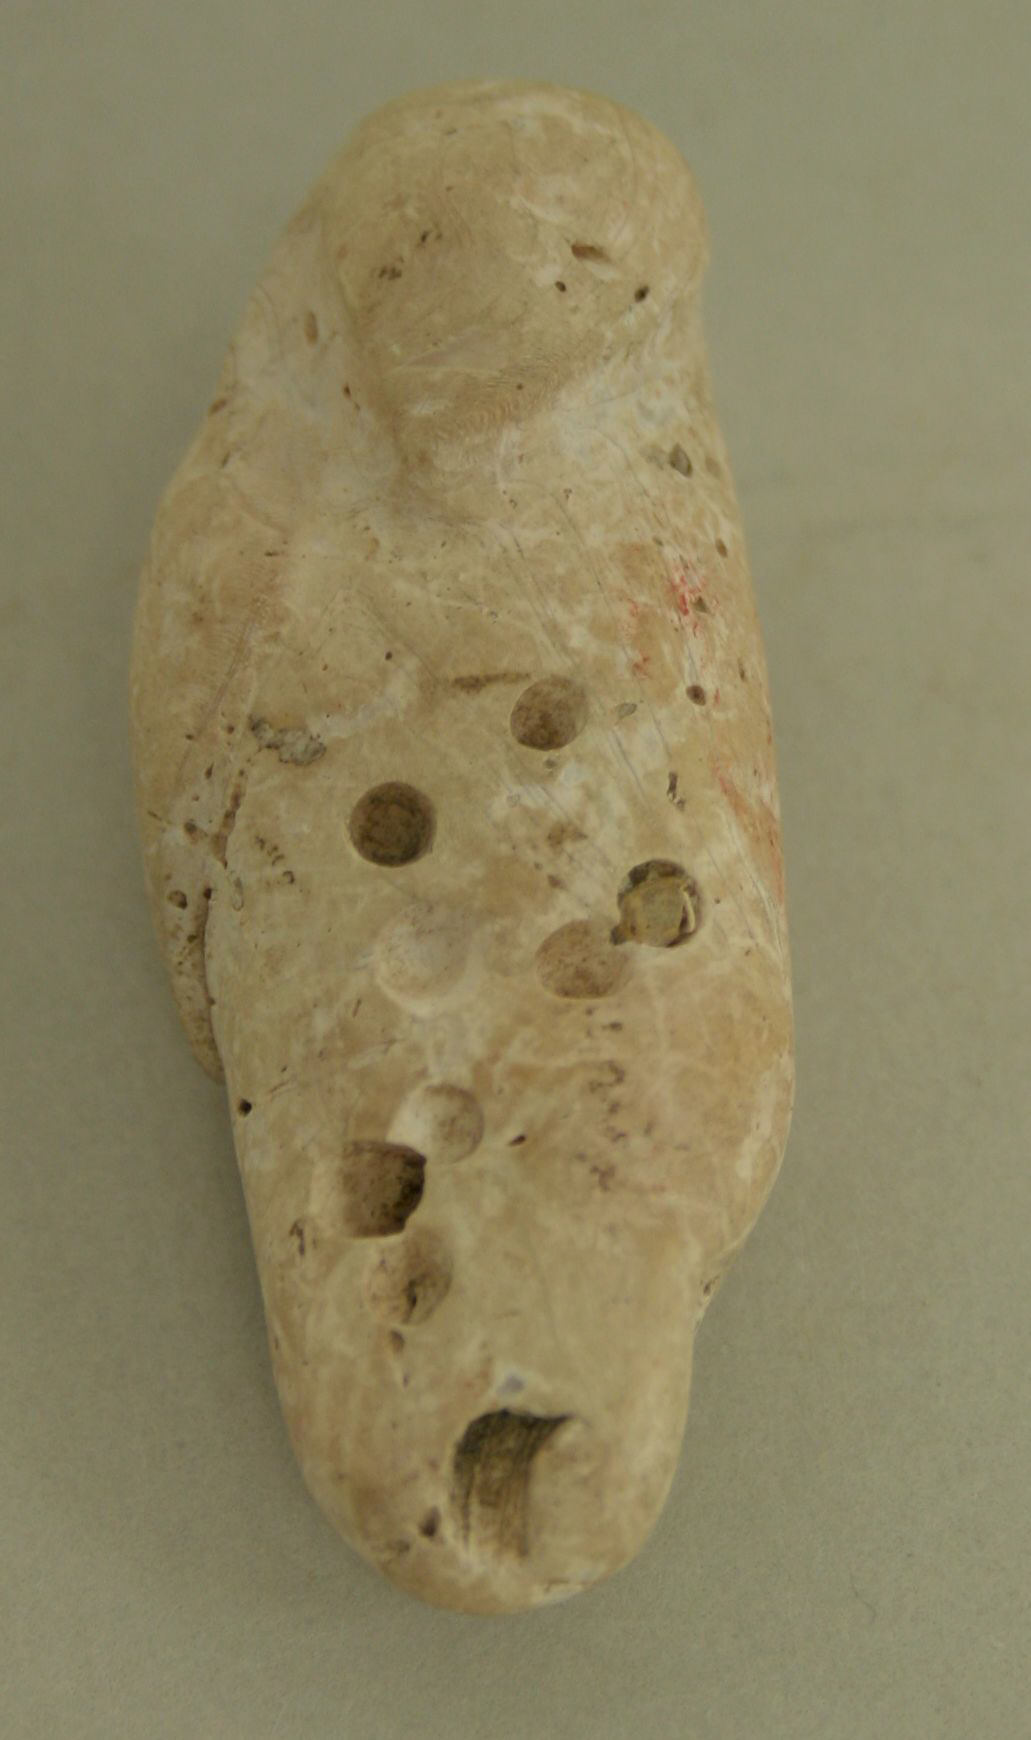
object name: figure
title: Figure (?)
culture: valdivia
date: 3000-2001 BCE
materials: shell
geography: ecuador